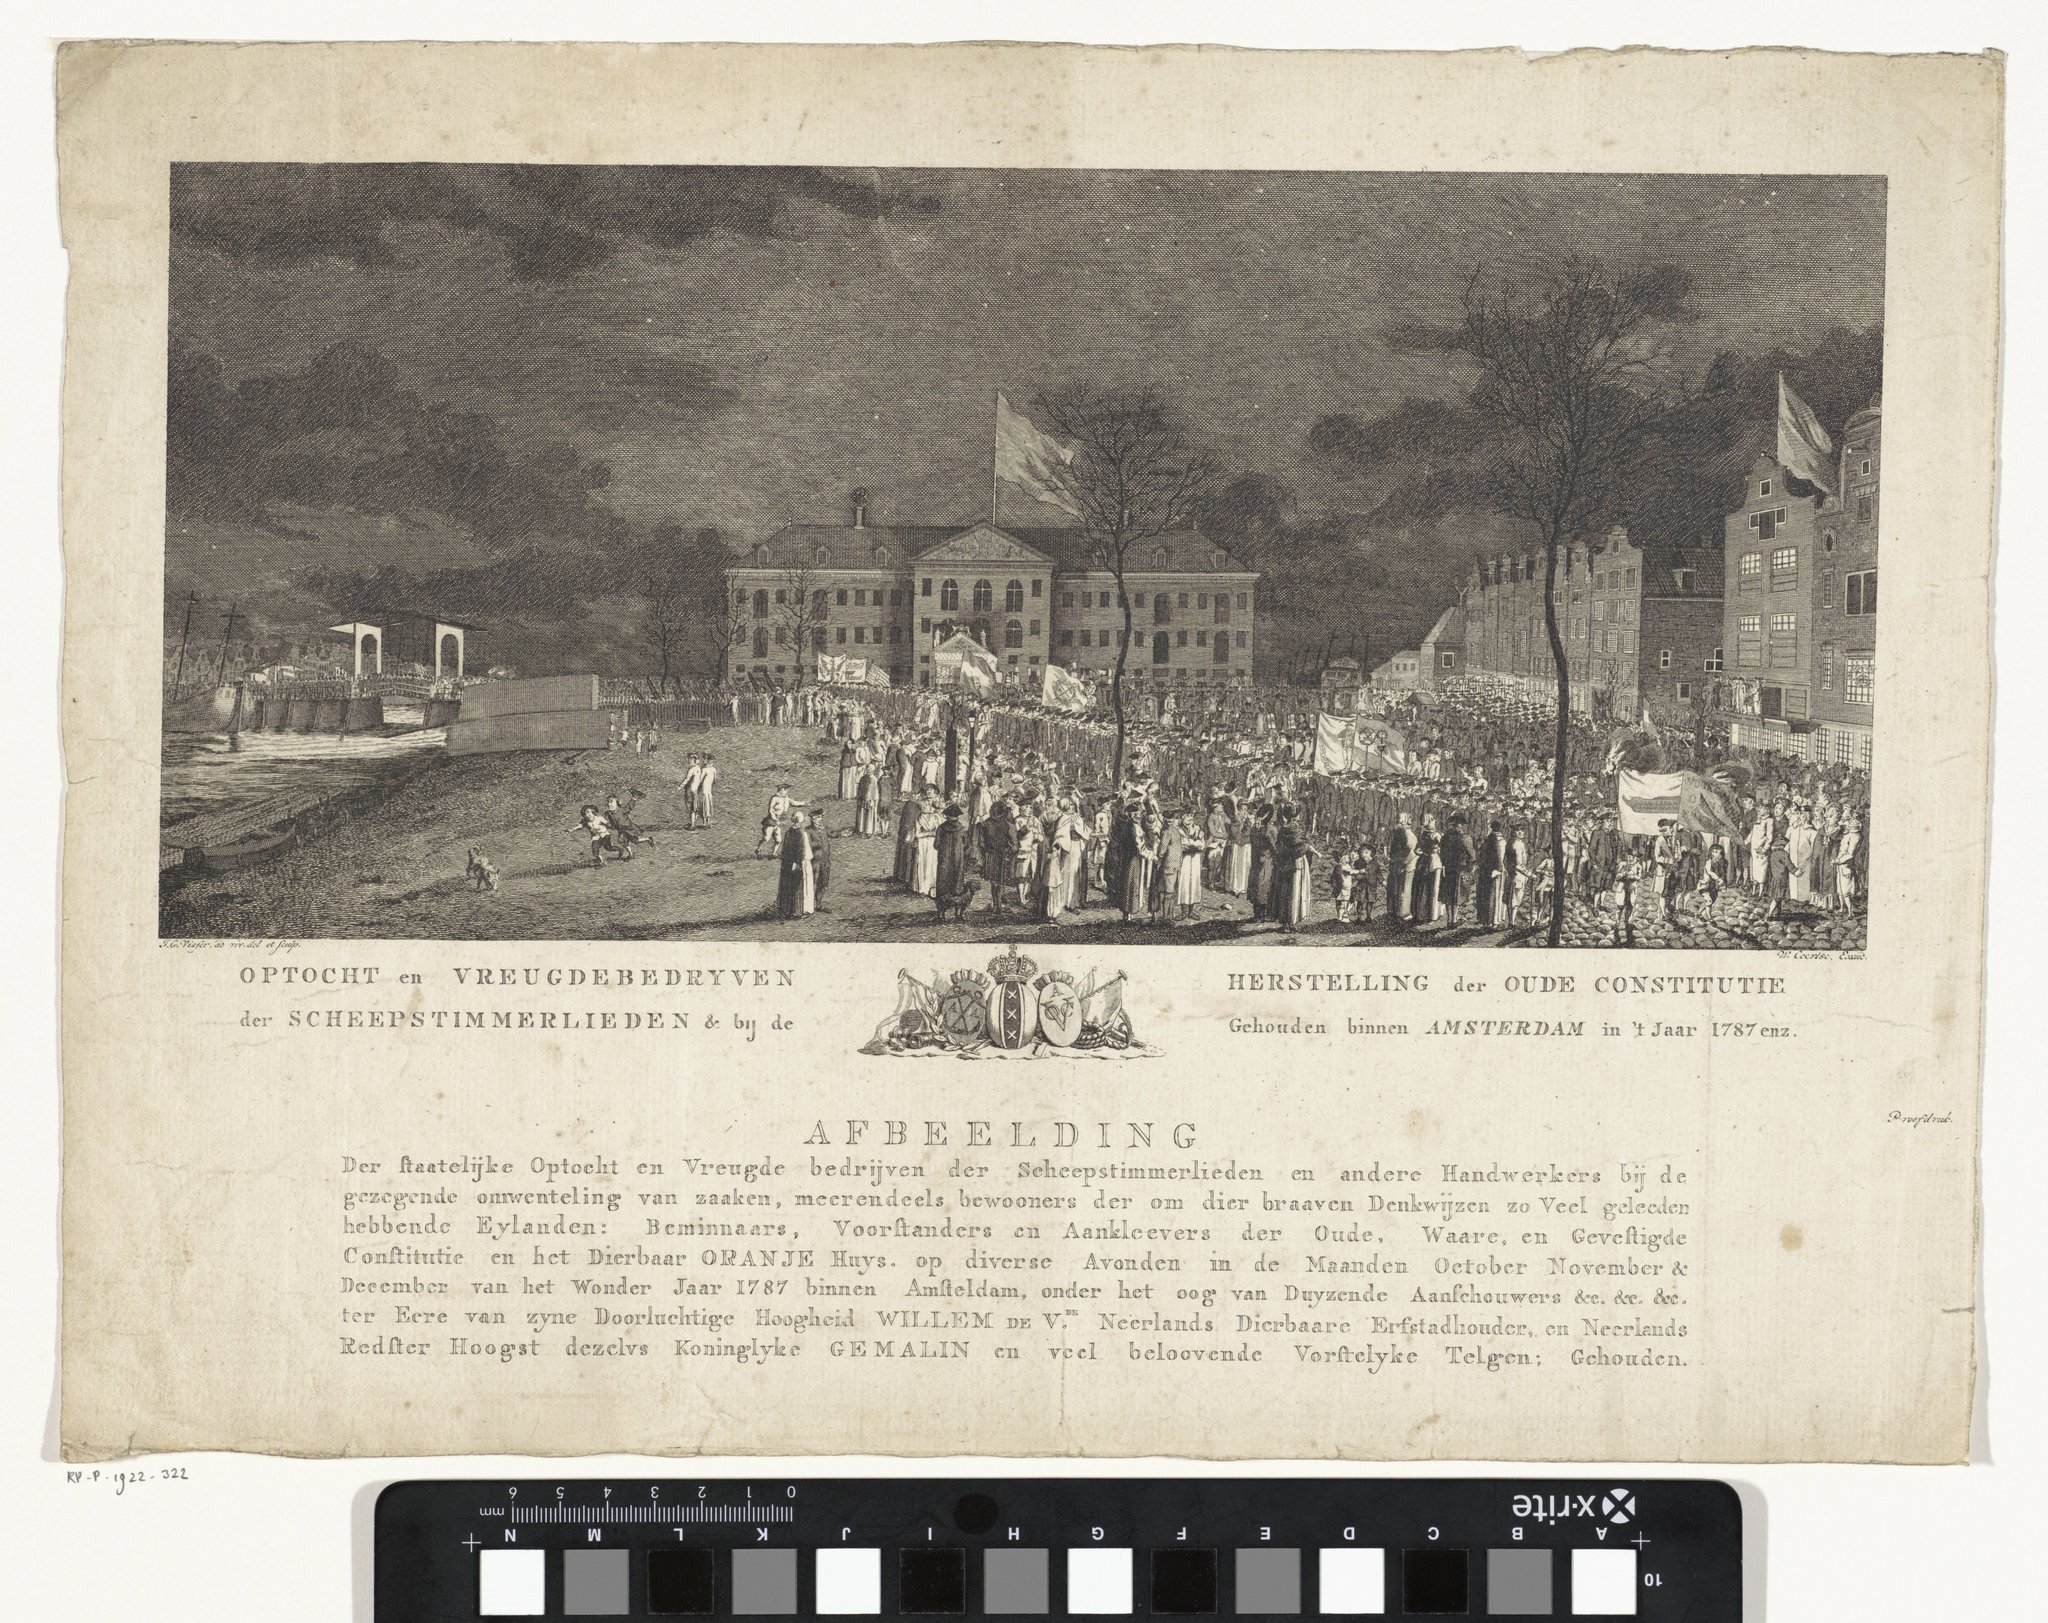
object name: print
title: Optocht en Vreugdebedryven der Scheepstimmerlieden & bij de Herstelling der Oude Constitutie Gehouden binnen Amsterdam in 't Jaar 1787 enz.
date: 1787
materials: paper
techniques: engraving, etching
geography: amsterdam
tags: the hague, william v (prince of orange), public festivities at other royal events, not meant or mentioned above (+ parade, pageant, cavalcade ~ festive activities)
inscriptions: collector's mark: Lugt 2233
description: Optocht van de Oranjegezinde Amsterdamse scheepstimmerlieden op het Kattenburgerplein te Amsterdam, ter viering van het herstel van stadhouder Willem V. Gehouden op verschillende avonden in de maanden oktober, november en december 1787. Hier waarschijnlijk de optocht van 20 december 1787. Onder de voorstelling het wapen van de Admiraliteit van Amsterdam.